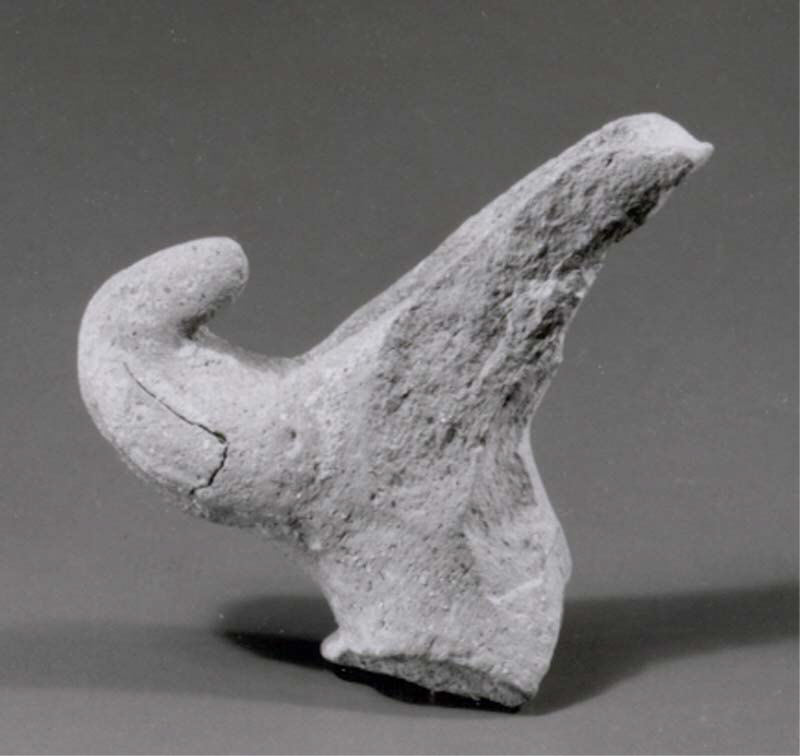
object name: spout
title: Beak spout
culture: iranian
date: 700-601 BCE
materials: ceramic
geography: iran